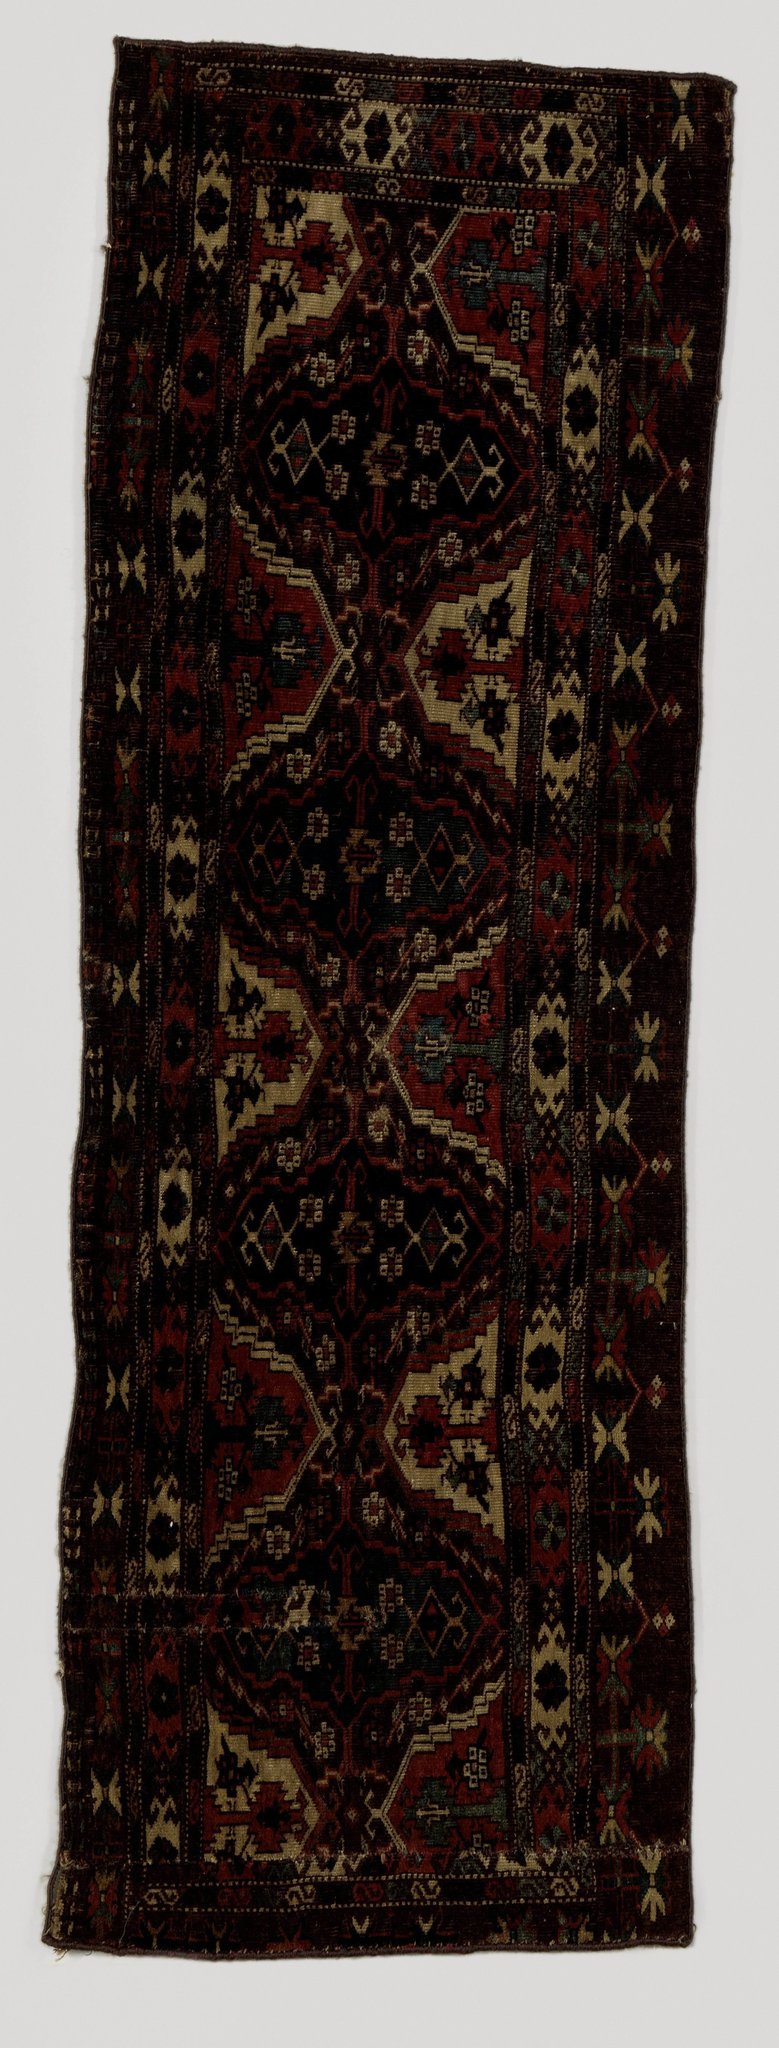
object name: dekkleed dier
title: Dekkleed, op het smalle veld versierd met ovale medaillonachtige vormen die deels gevuld zijn met een boom en een vogelachtig dier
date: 1800-1825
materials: wool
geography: central asia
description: Dekkleed, wellicht voor een kameel. Het brede smalle veld is versierd met ovale medaillonachtige vormen, z.g. ertmen guls, deels gevuld met een boom en een vogelachtig dier. Tussen de guls een raster van twijgen.